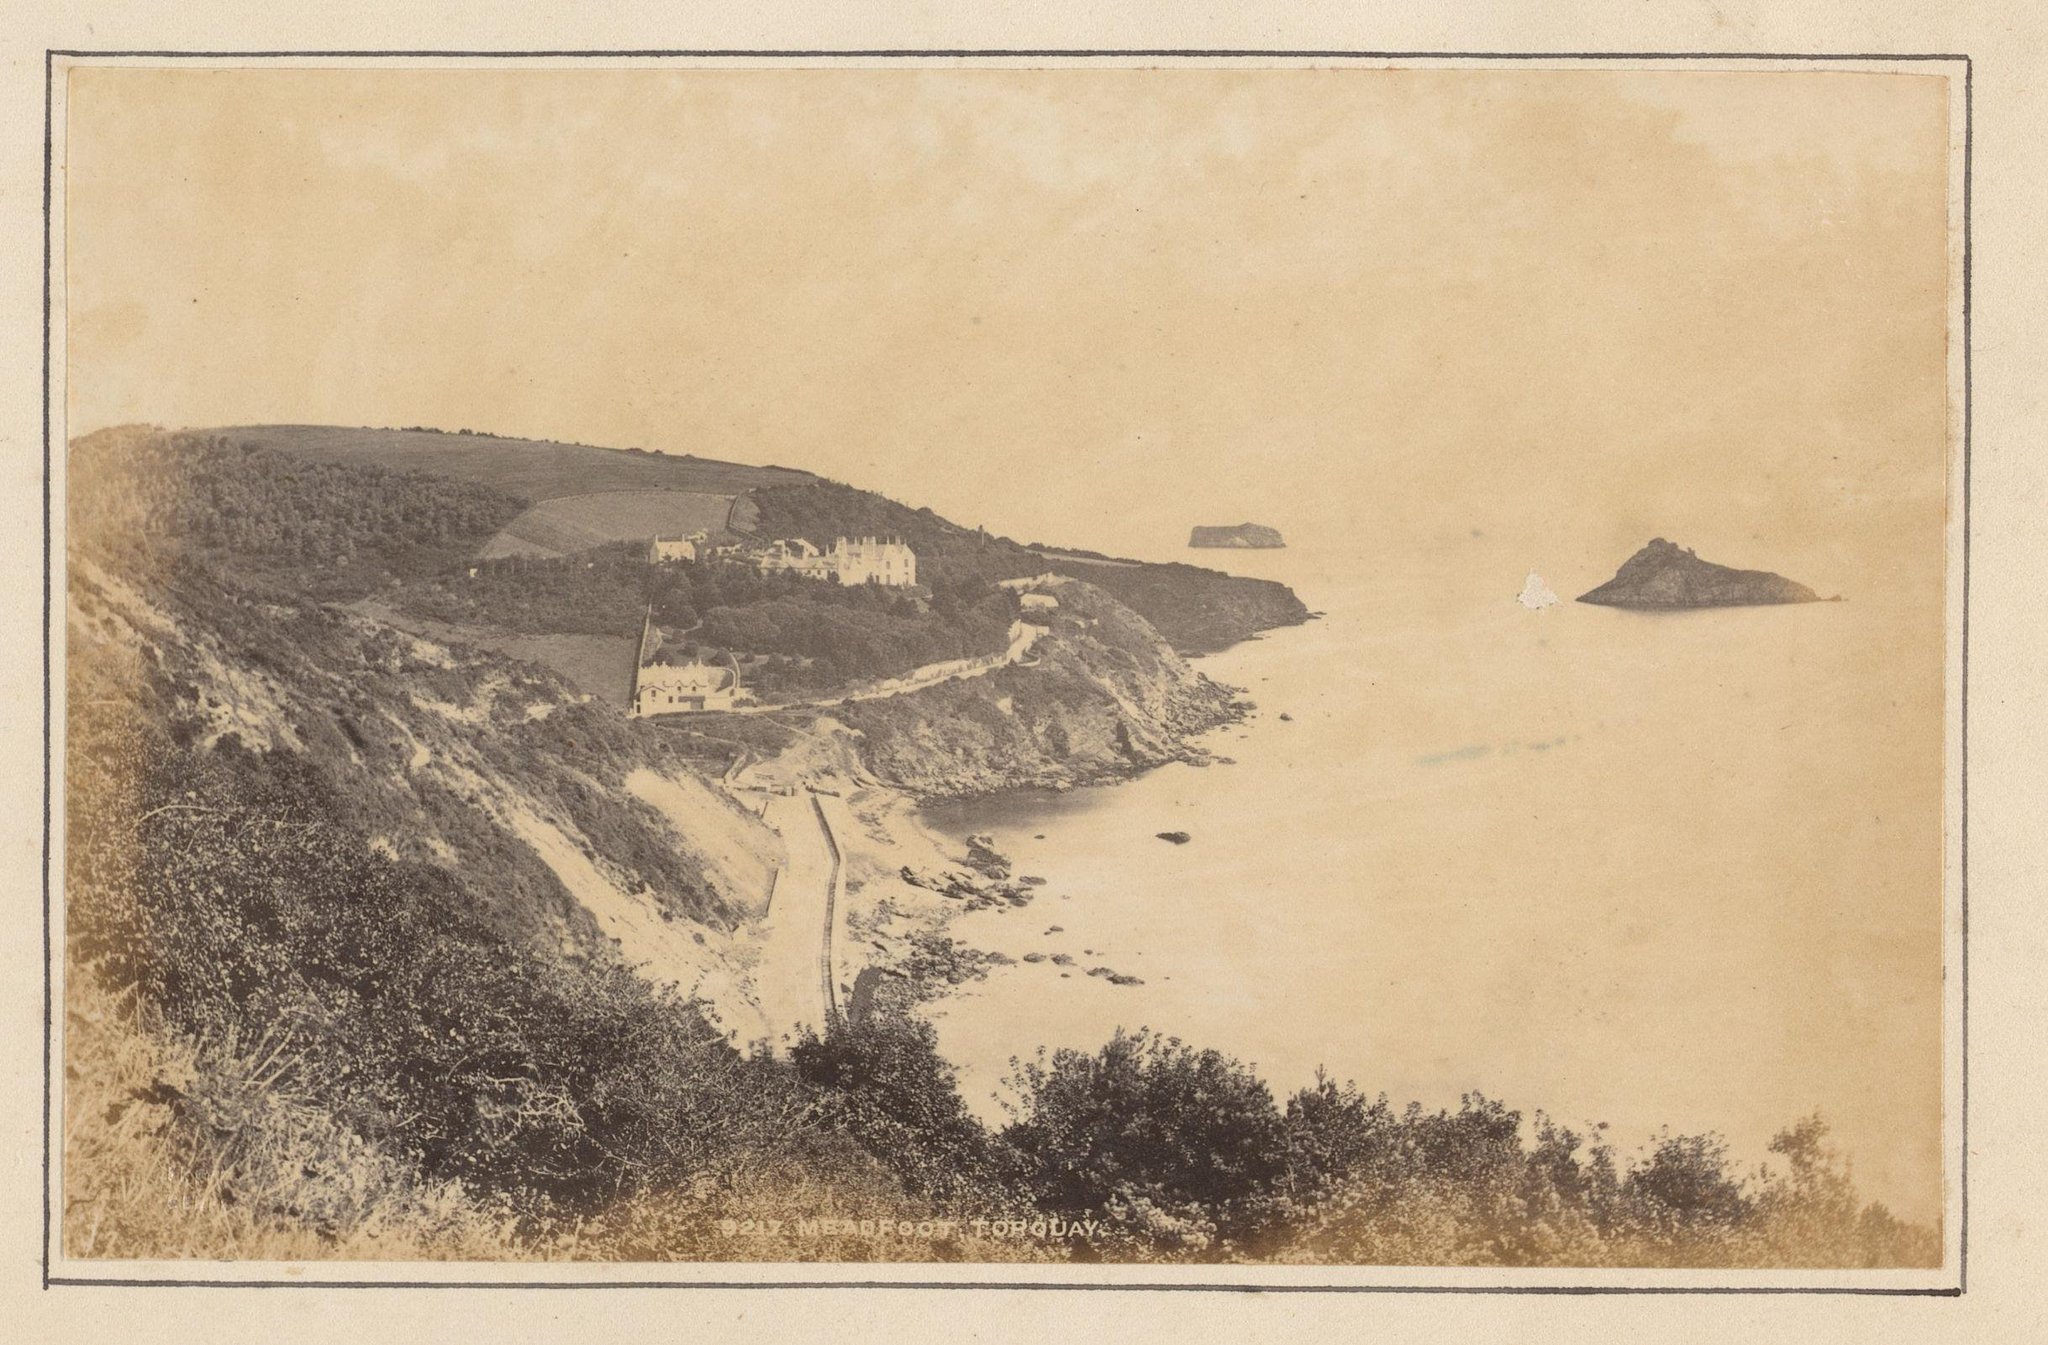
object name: album leaf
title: Meadfoot. Torquay.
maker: Anonymous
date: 1870-1890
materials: paper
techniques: albumen print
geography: torbay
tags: gulf, bay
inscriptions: inscription: ‘9217. Meadfoot Torquay’